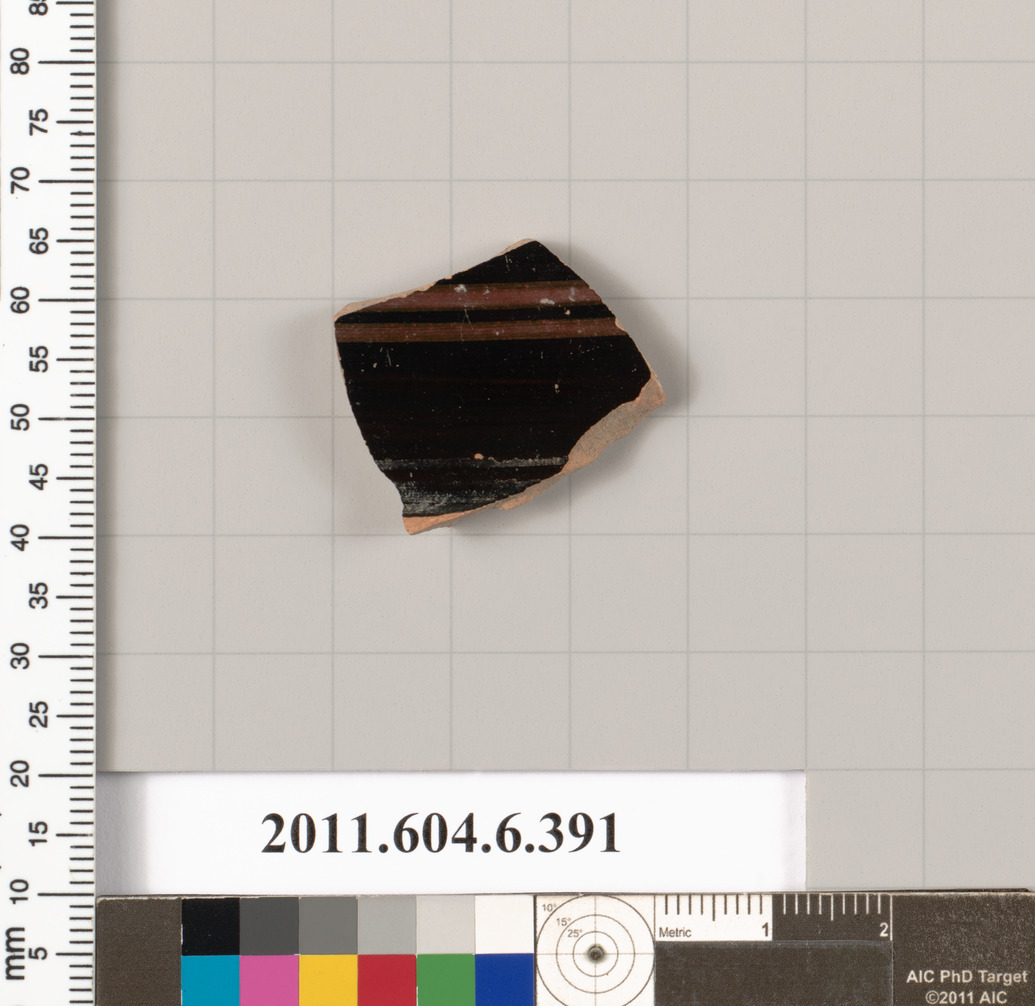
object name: undetermined open shape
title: Terracotta fragment of an open shape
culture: greek, attic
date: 600-401 BCE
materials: terracotta